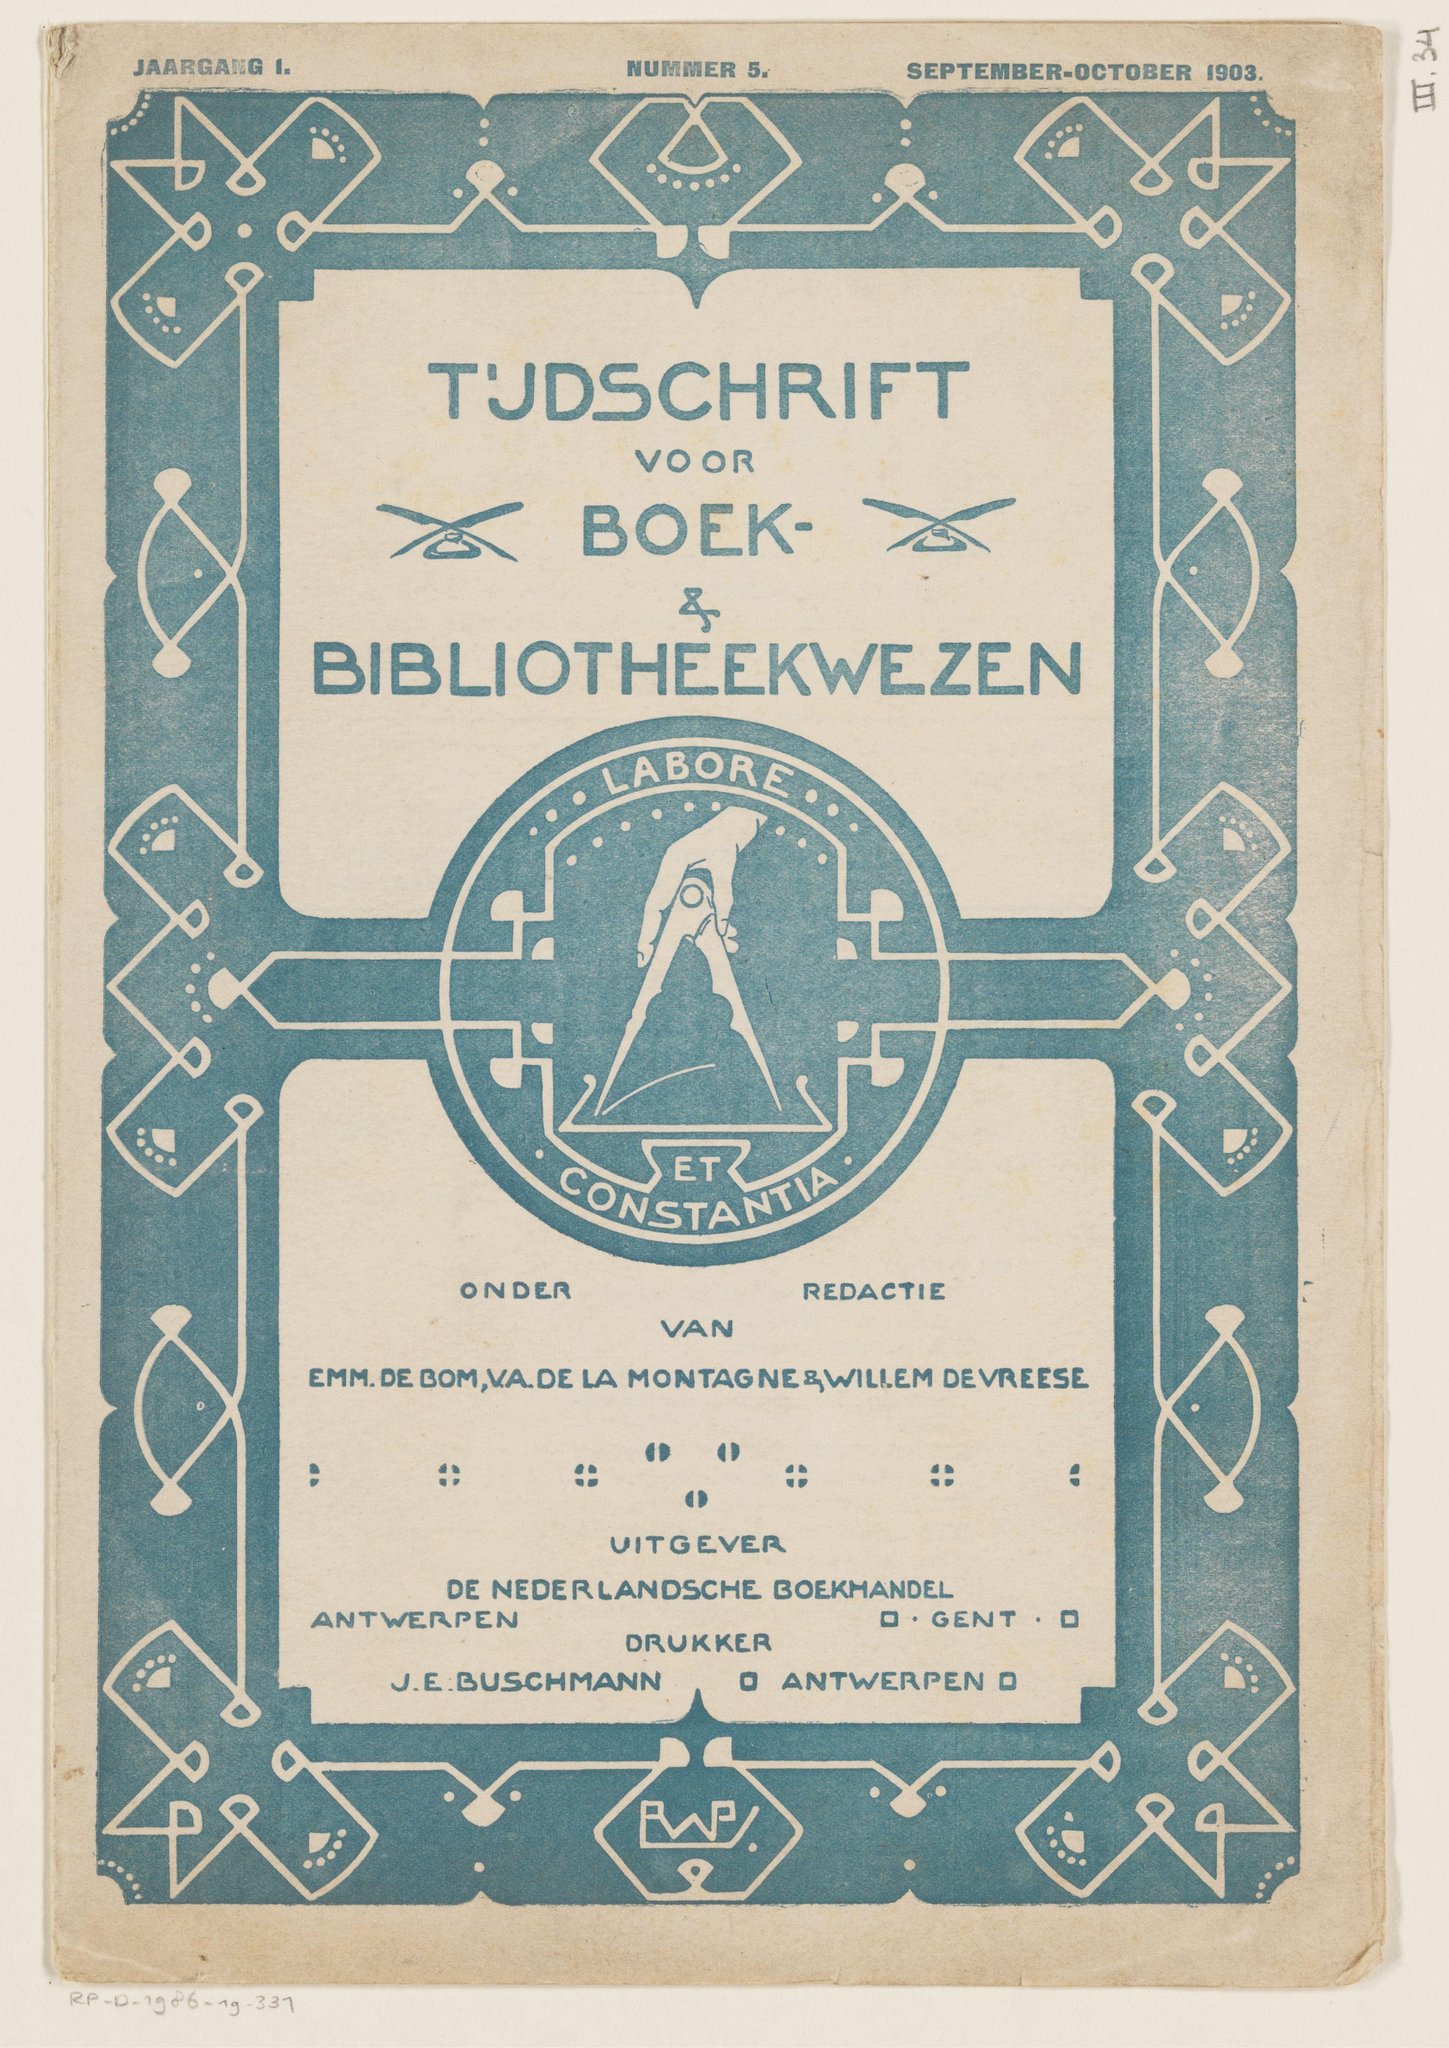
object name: photomechanical print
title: Omslag van: Tijdschrift voor boek- en bibliotheekwezen, september-october 1903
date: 1903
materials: paper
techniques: printing block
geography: antwerp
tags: compasses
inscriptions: collector's mark: ‘BIBLIOTHEEK/ VEREENIGING TER BEVORDERING VAN DE BELANGEN DES BOEKHANDELS’, collector's mark: ‘R:MVS.’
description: Ornamenteel kader met in het midden een cirkel met een hand met een passer en het motto 'Labore et Constantia'.